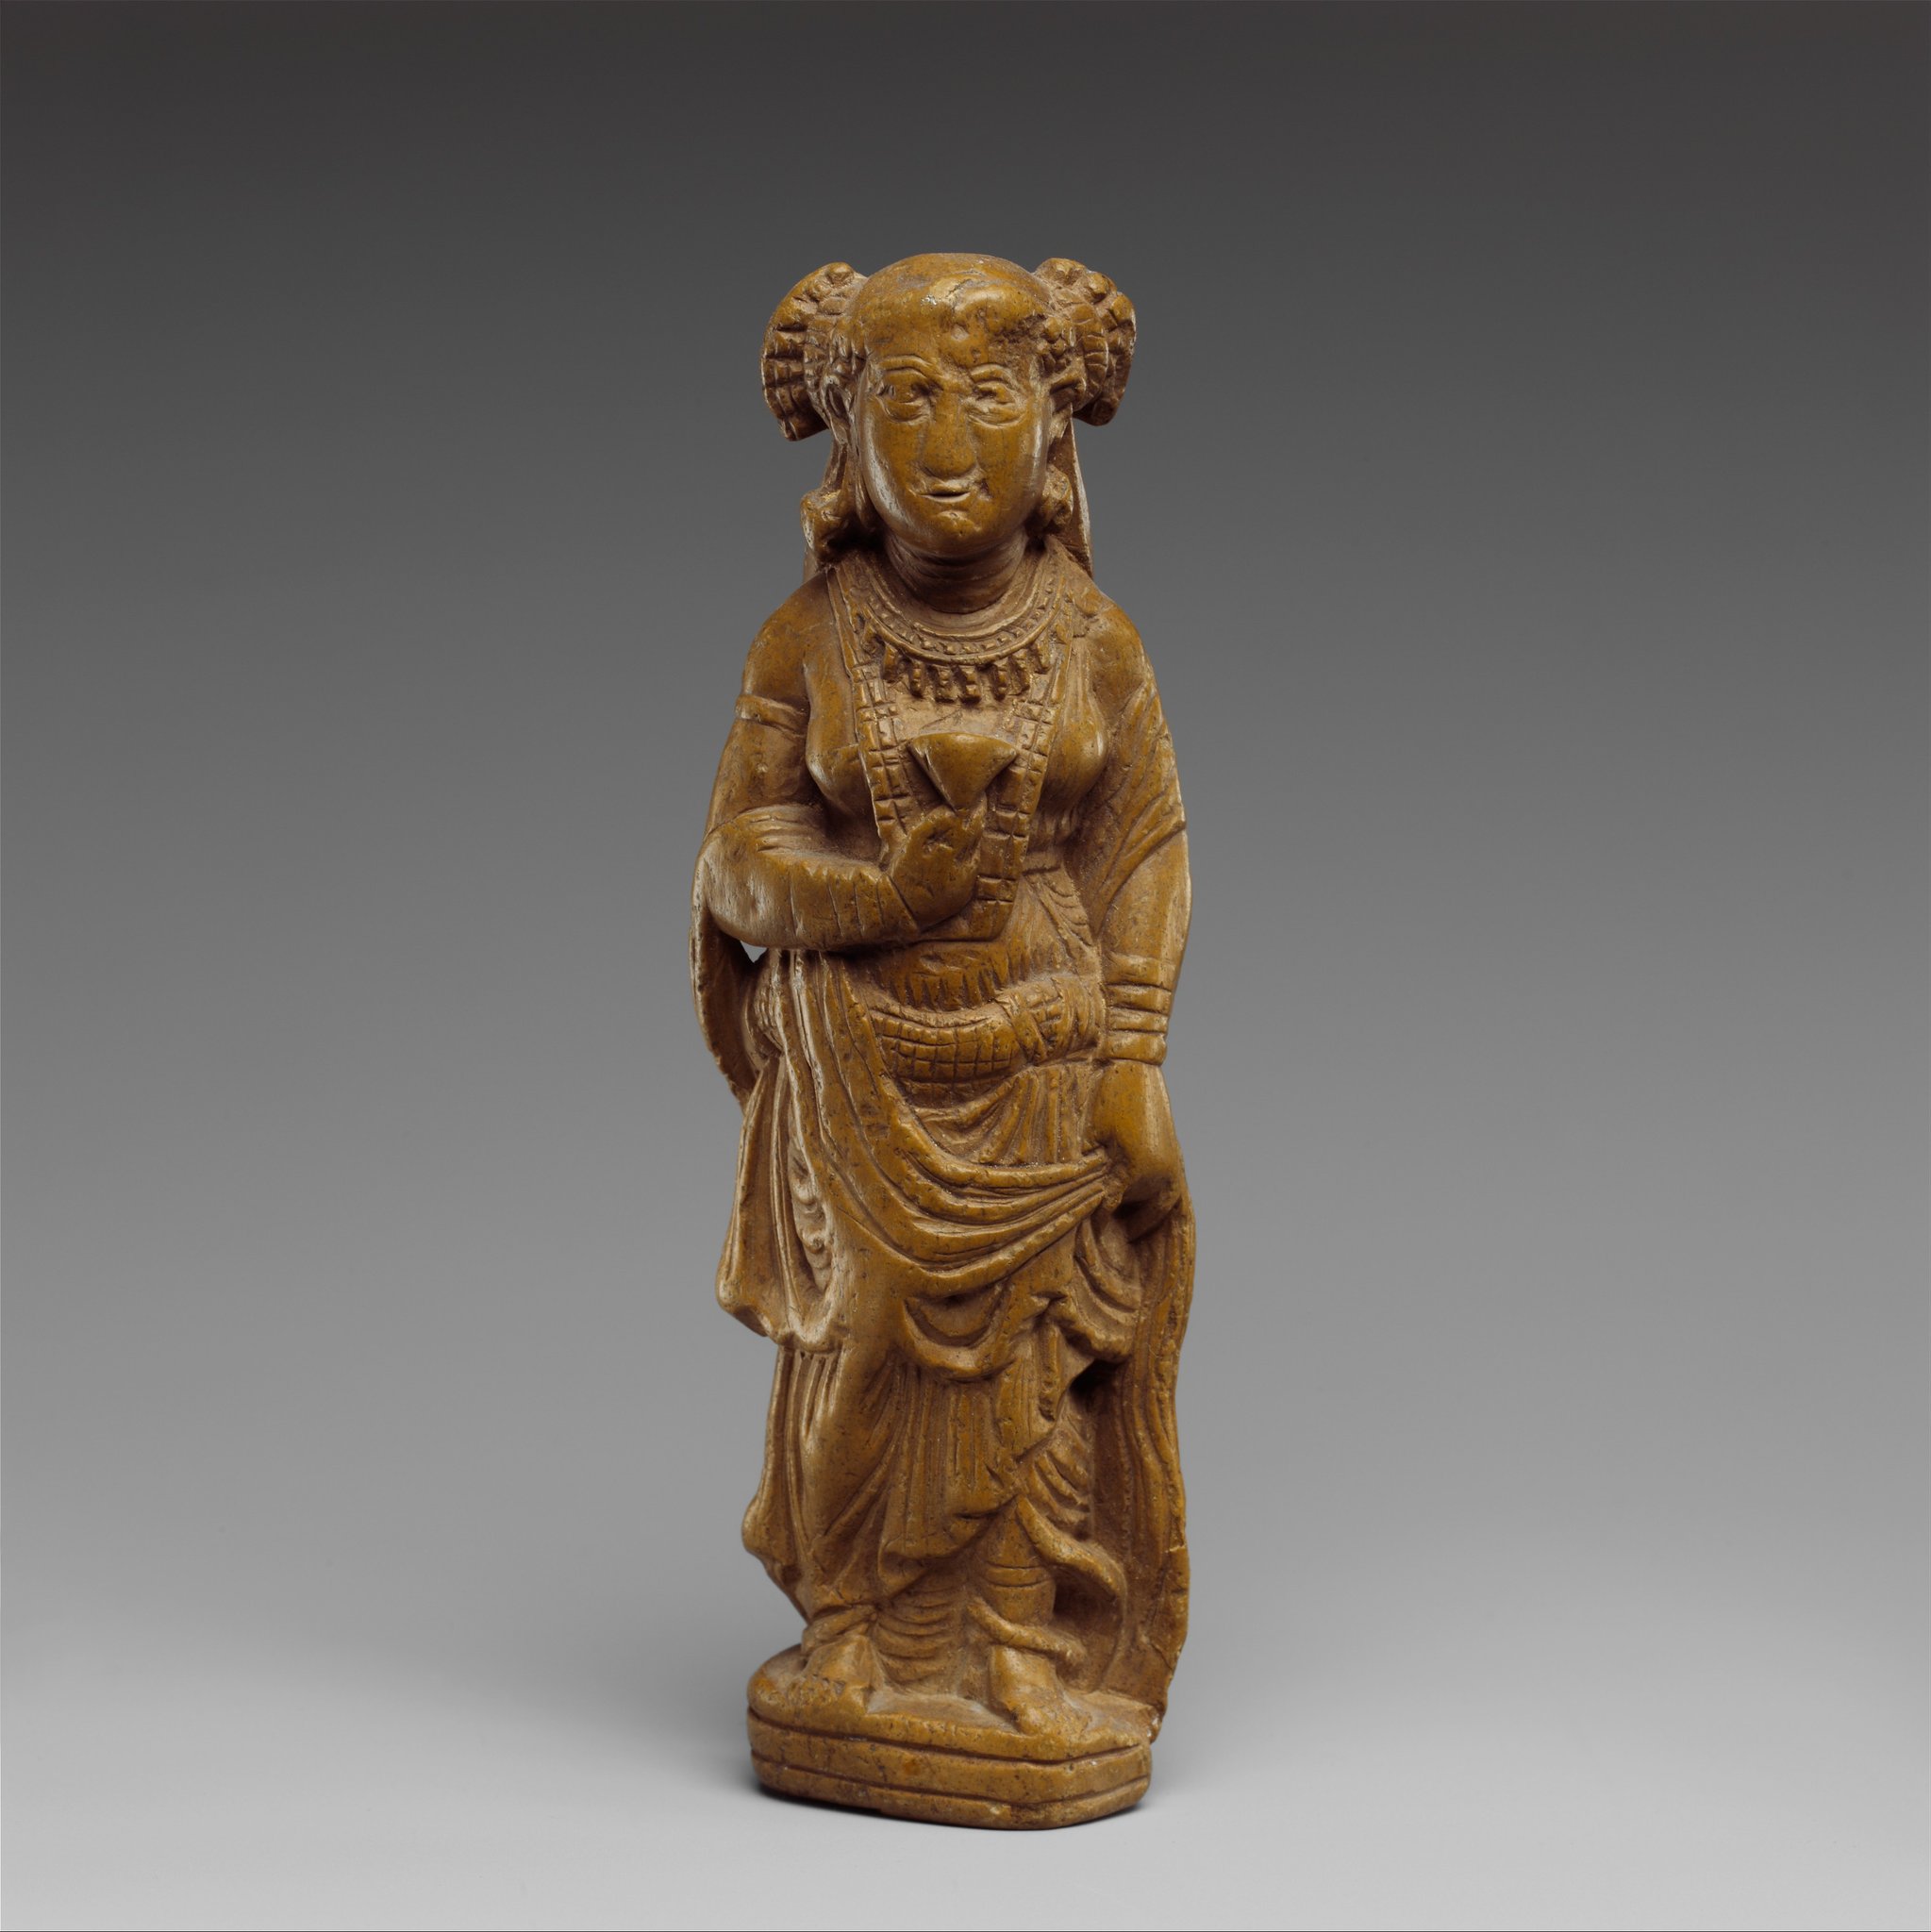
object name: mirror handle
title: Mirror Handle: Standing Woman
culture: gandhara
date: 100-1 BCE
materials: stone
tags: kashmir,women